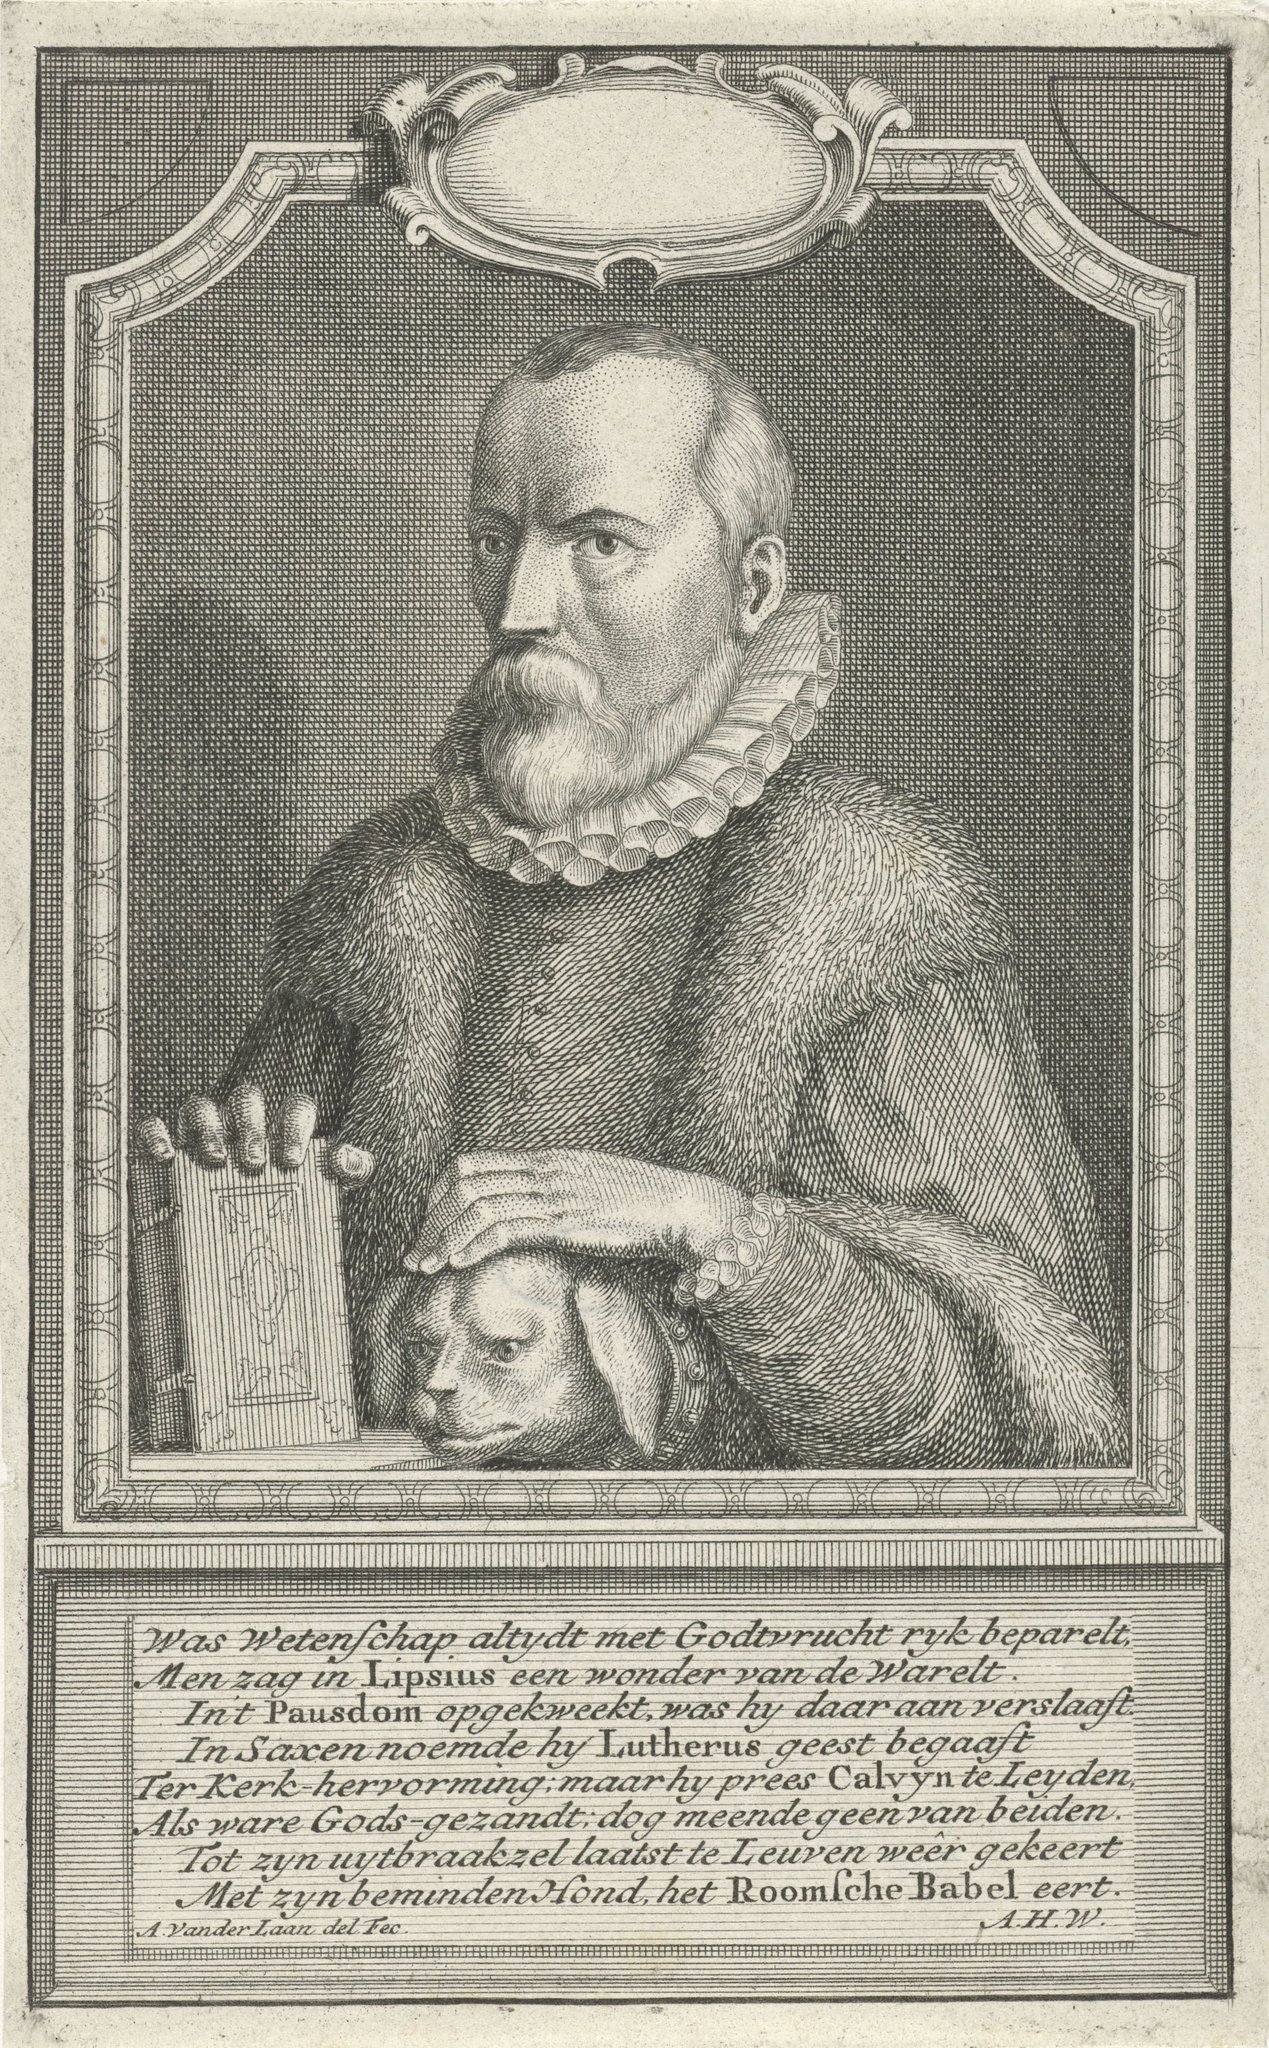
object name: print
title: Portret van Justus Lipsius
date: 1694-1755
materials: paper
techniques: engraving, etching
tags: louvain, justus lipsius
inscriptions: collector's mark: Lugt 2228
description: Portretbuste naar links van Justus Lipsius, humanist en geleerde, blootshoofds en met bontkraag. Zijn linkerhand rust op de kop van een hond, de rechterhand steunt op een boek. Rondom een ornamentele omlijsting, onder het portret de naam van de geportretteerde en een achtregelig Nederlands vers.